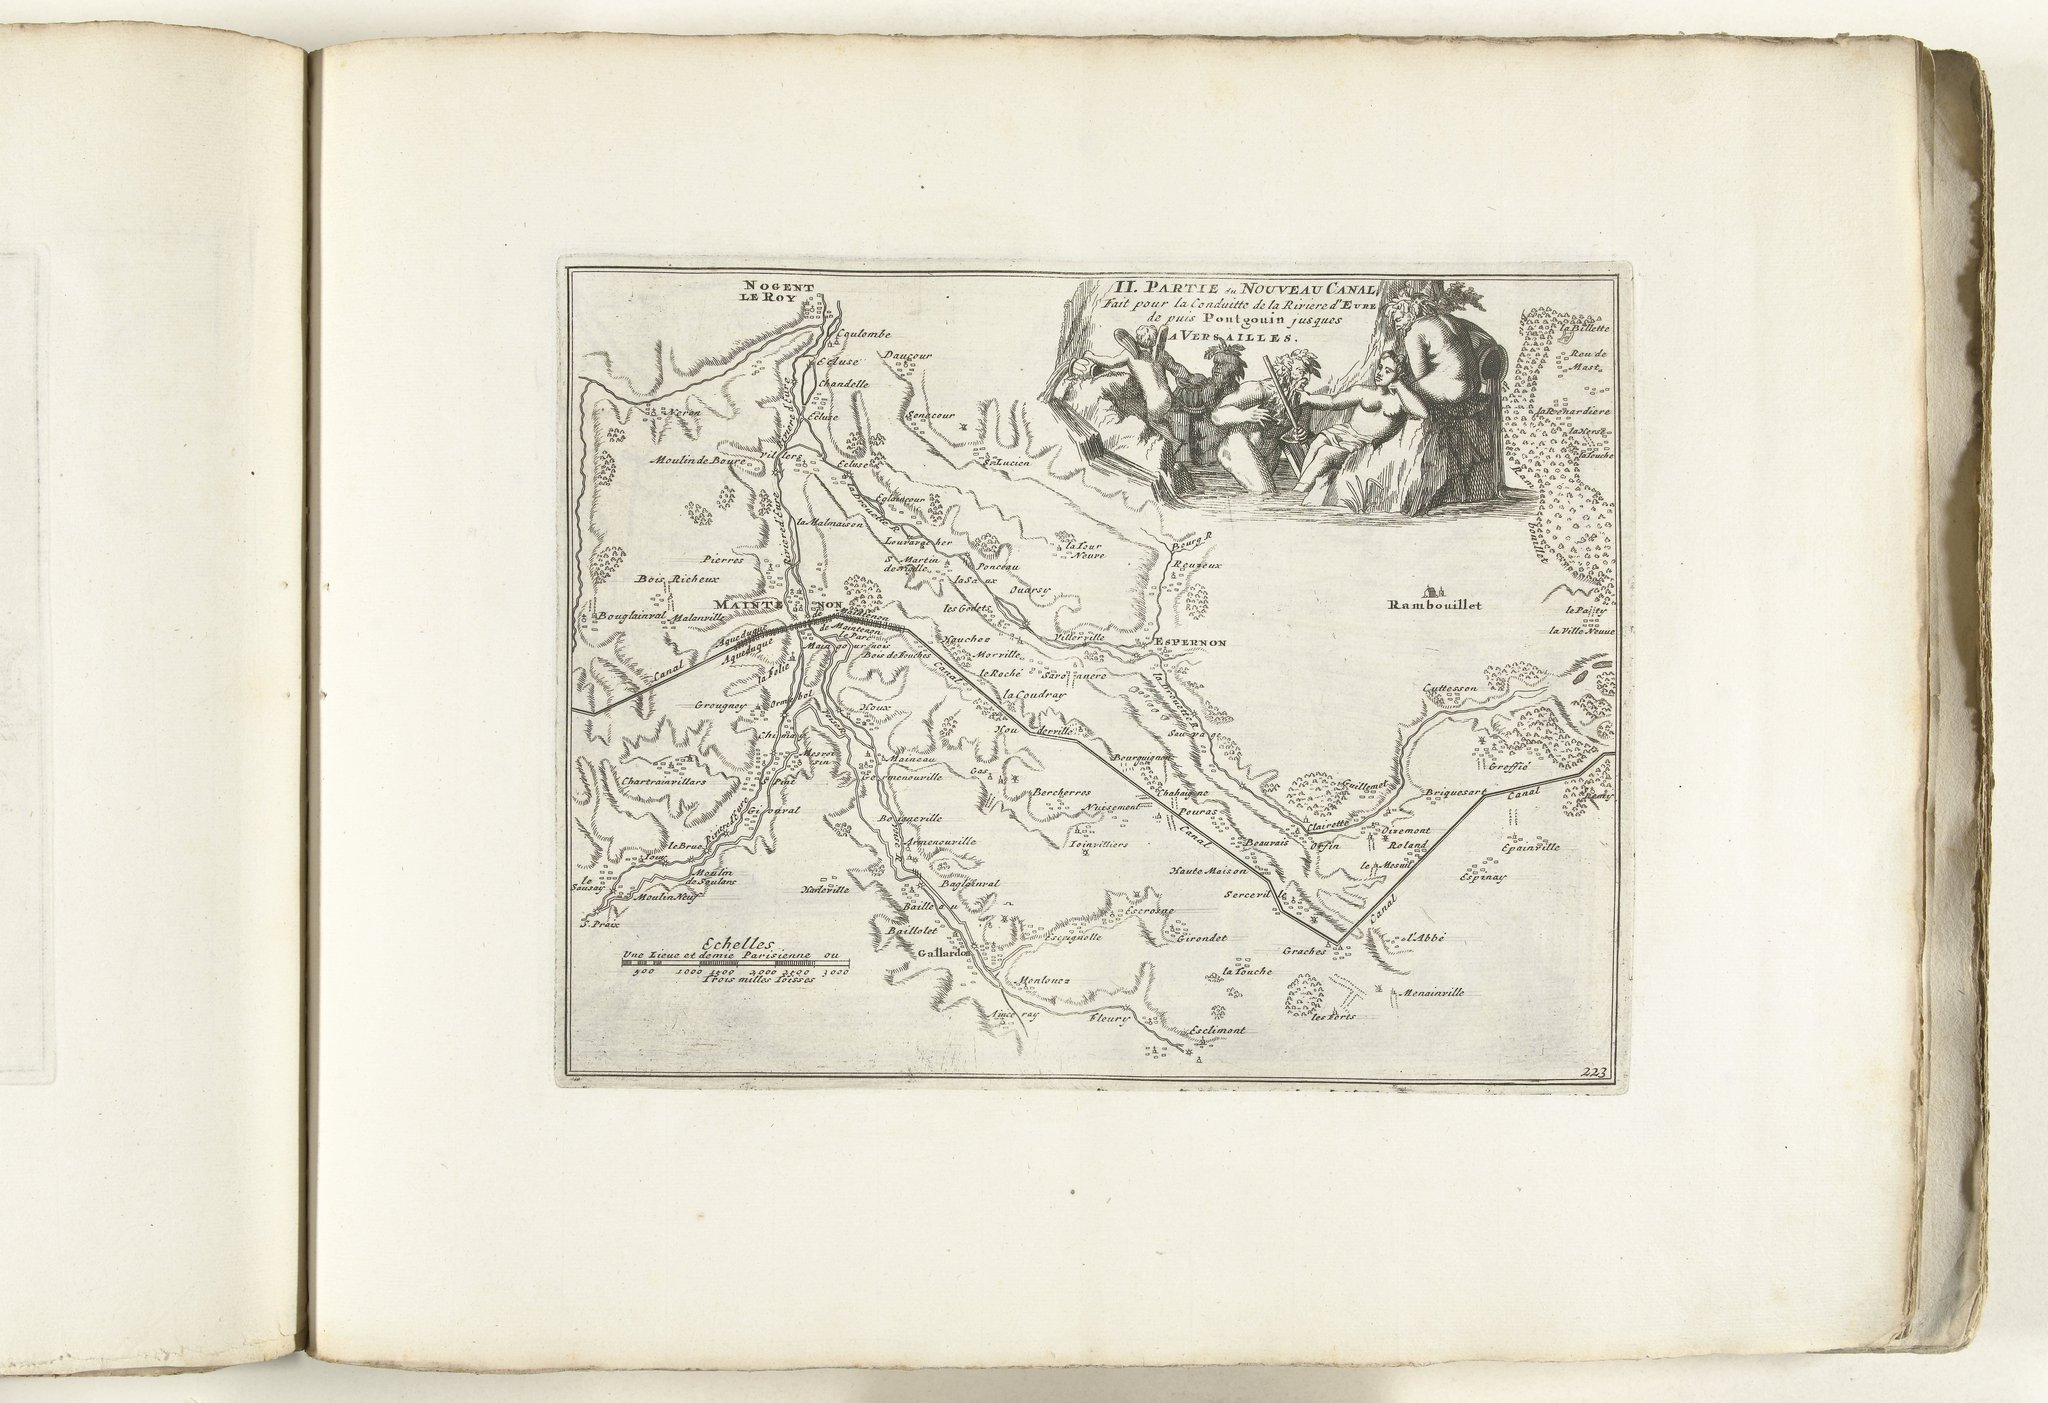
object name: print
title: II. Partie du Nouveau Canal Fait pour la Conduitte de la Riviere d'Eure depuis Pontgouin jusques a Versailles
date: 1702-1703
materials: paper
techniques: etching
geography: northern netherlands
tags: maps of separate countries or regions, canal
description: Kaart van het nieuwe kanaal dat water van de rivier de Eure leidt van Pontgouin naar Versailles (deel II). Plaat nr. 223 in het prentwerk bestaande in totaal uit 276 genummerde platen van vermaarde sterke steden en vestingen in het kader van de Spaanse Successieoorlog. Voor het merendeel zijn deze platen gekopieerd naar de anonieme Franse platen: in Les forces de l'Europe en in: Le theatre de la guerre, dans les Pays-Bas, beide oorspronkelijk uitgegeven door Nicolas de Fer te Parijs (1693-1697) in het kader van de Negenjarige Oorlog. Titel en opschriften in de plaat in het Frans.